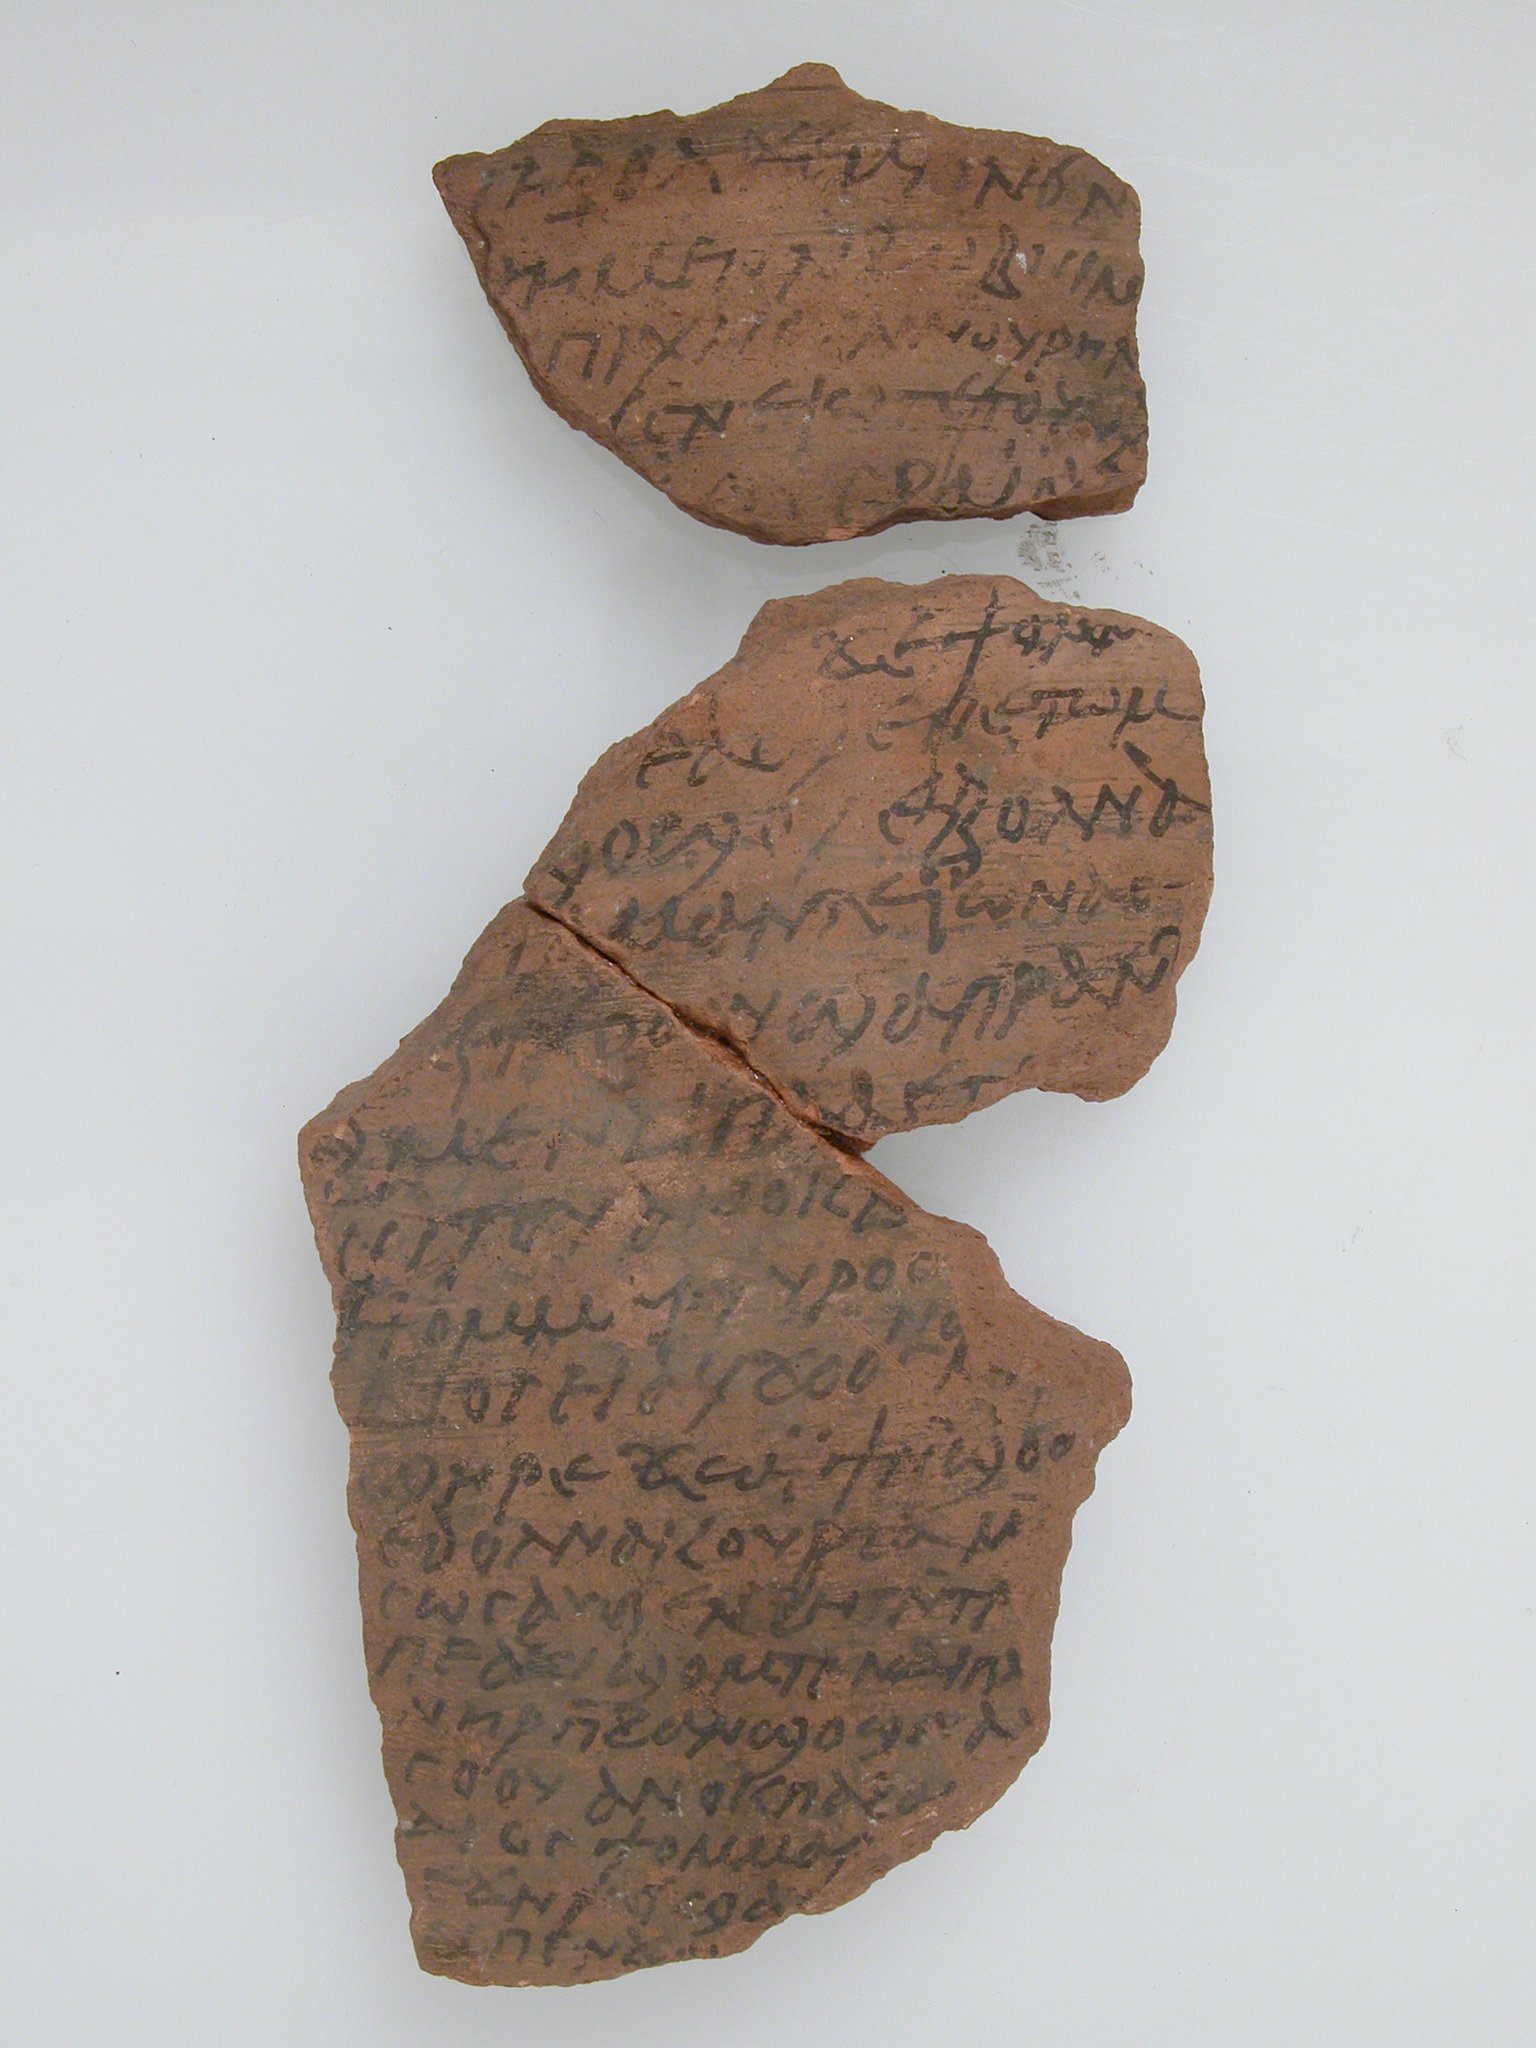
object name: ostrakon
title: Ostrakon with a Legal Letter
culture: coptic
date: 580-640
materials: ink, pottery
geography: egypt